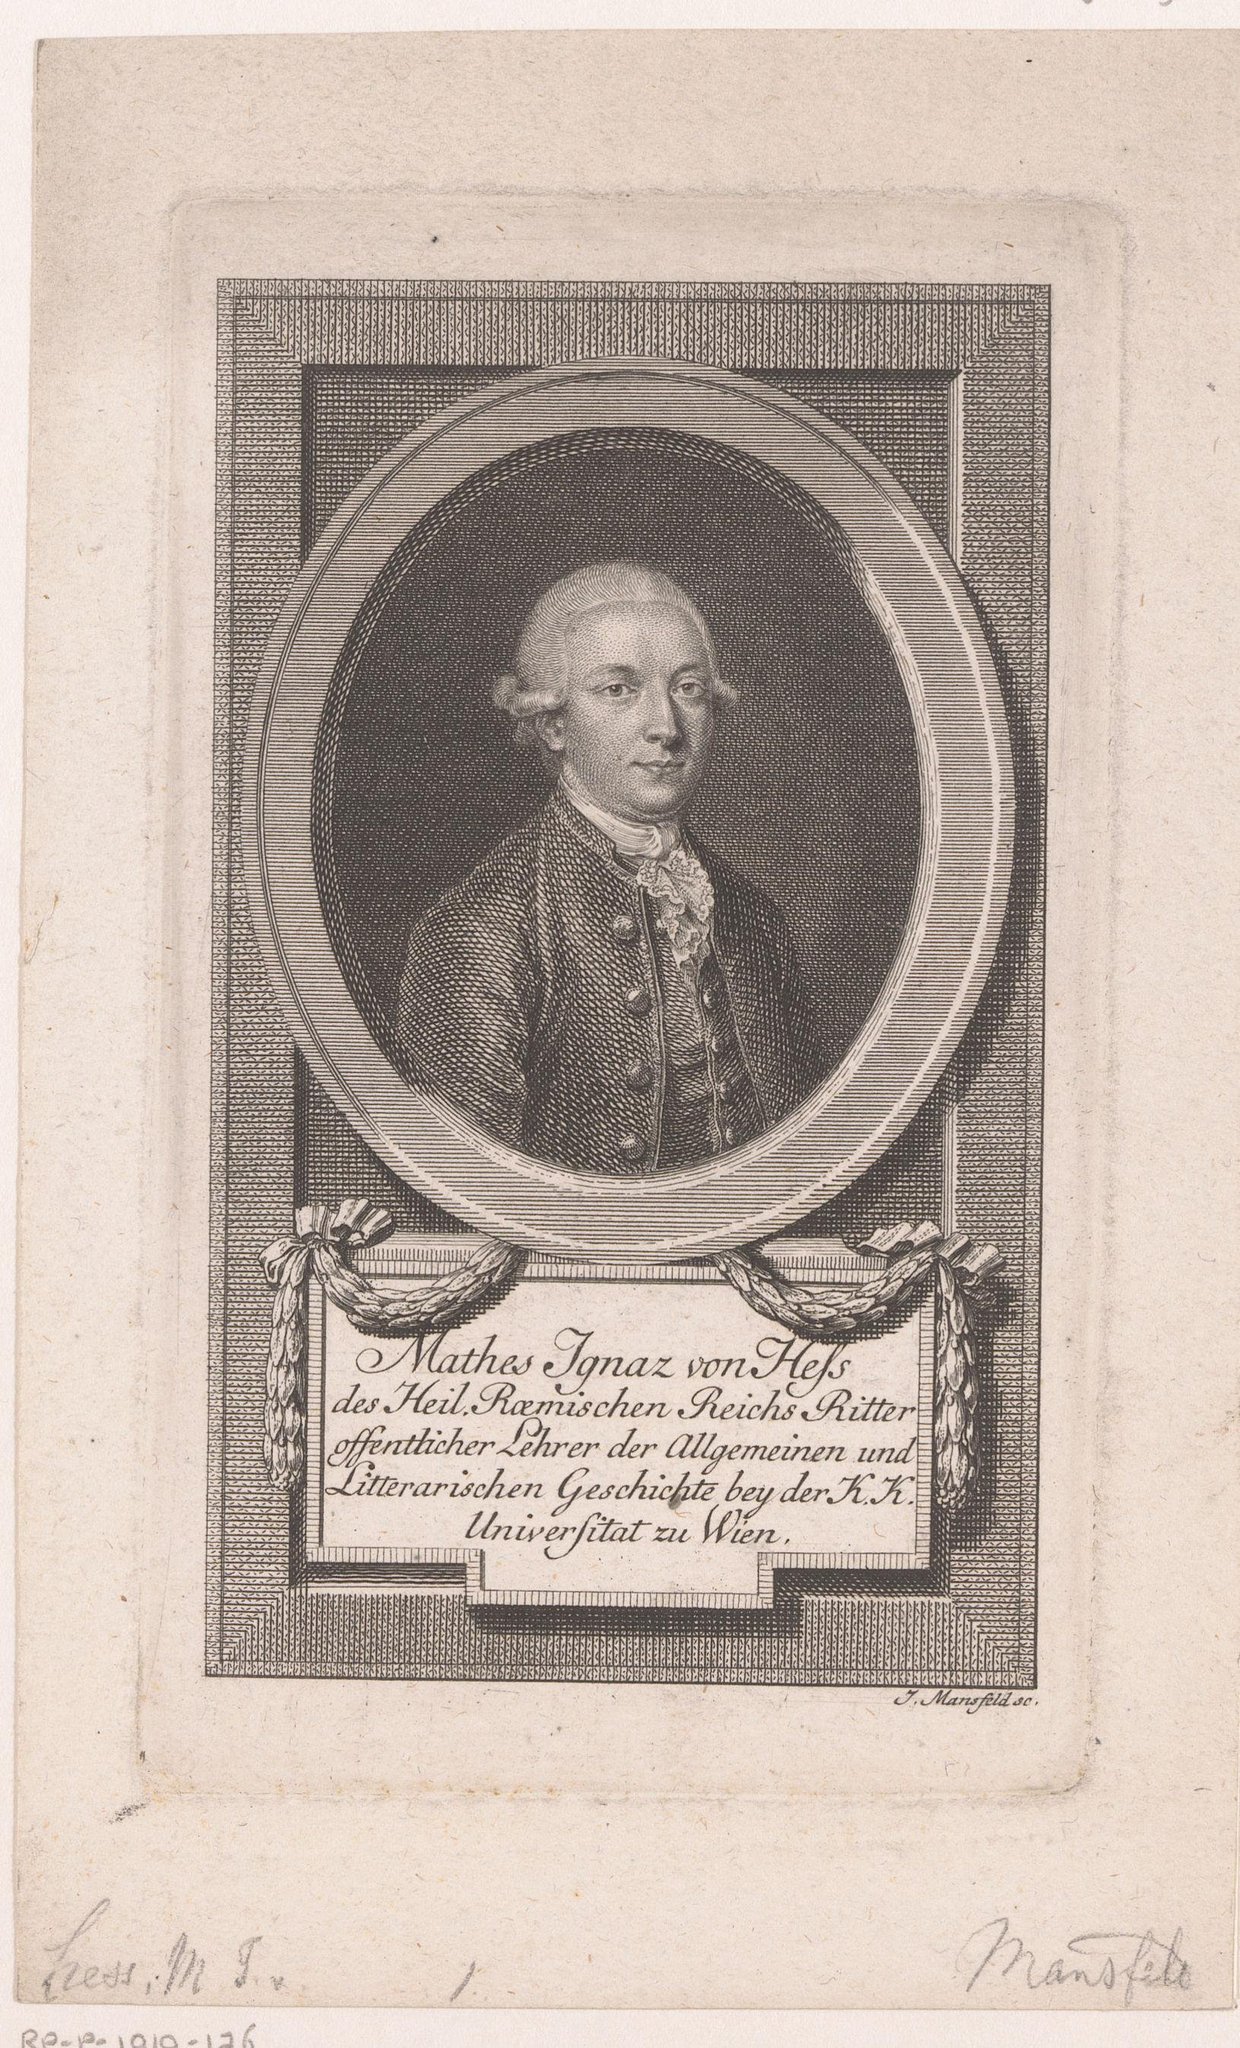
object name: print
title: Portret van Matthias Ignaz von Hess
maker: johann ernst mansfeld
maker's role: print maker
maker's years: 1739-1796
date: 1749-1796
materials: paper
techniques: engraving, etching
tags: historical persons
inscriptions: collector's mark: Lugt 2228